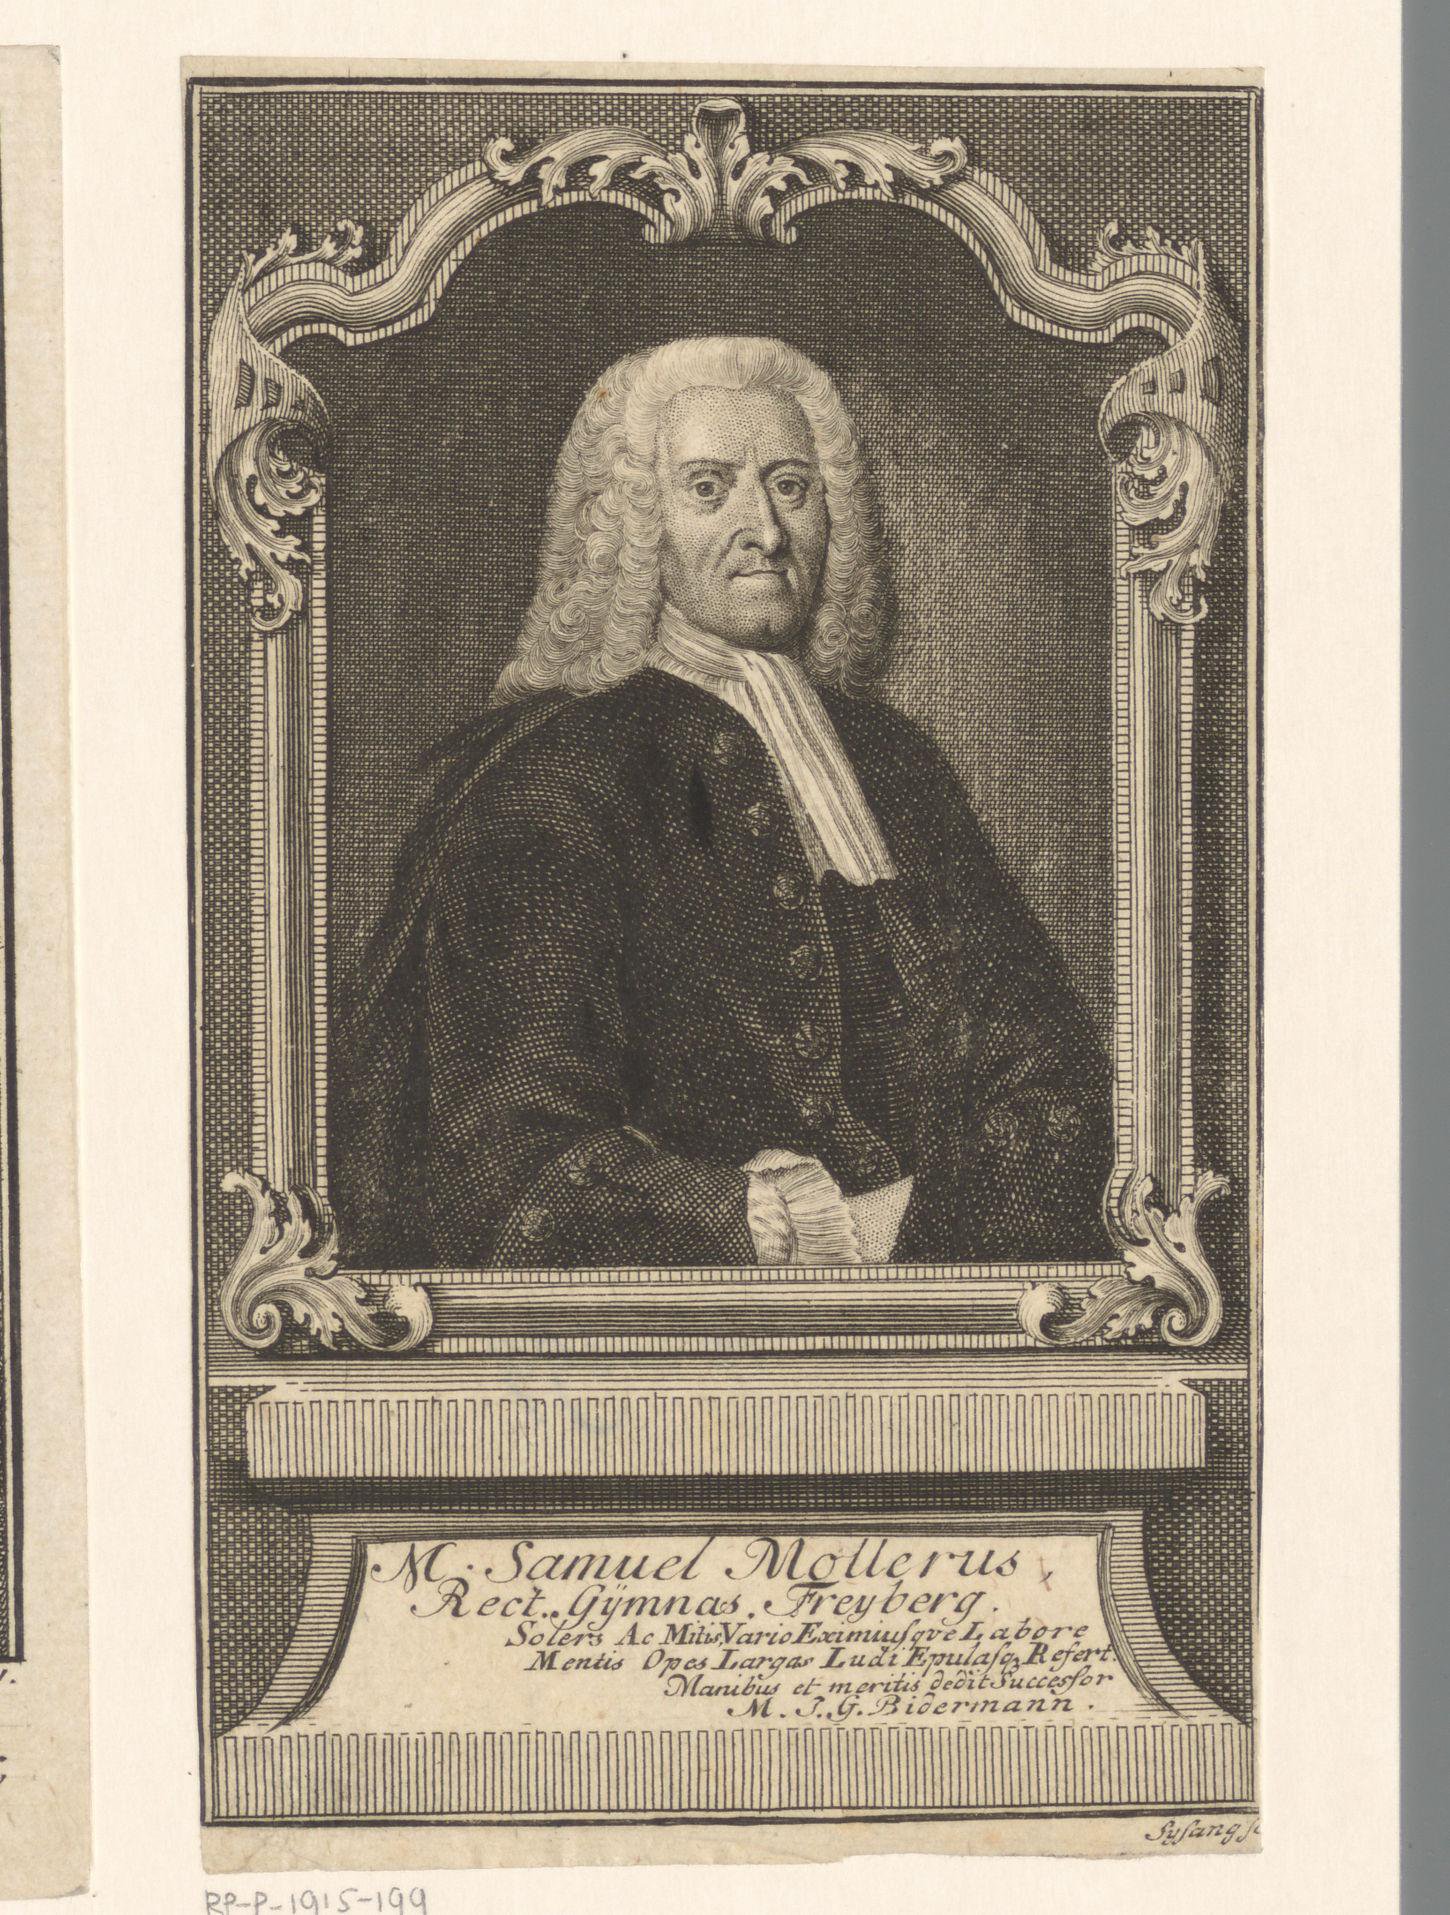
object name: print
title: Portret van Samuel Möller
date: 1715-1757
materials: paper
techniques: engraving, etching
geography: germany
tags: historical persons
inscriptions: collector's mark: Lugt 2228